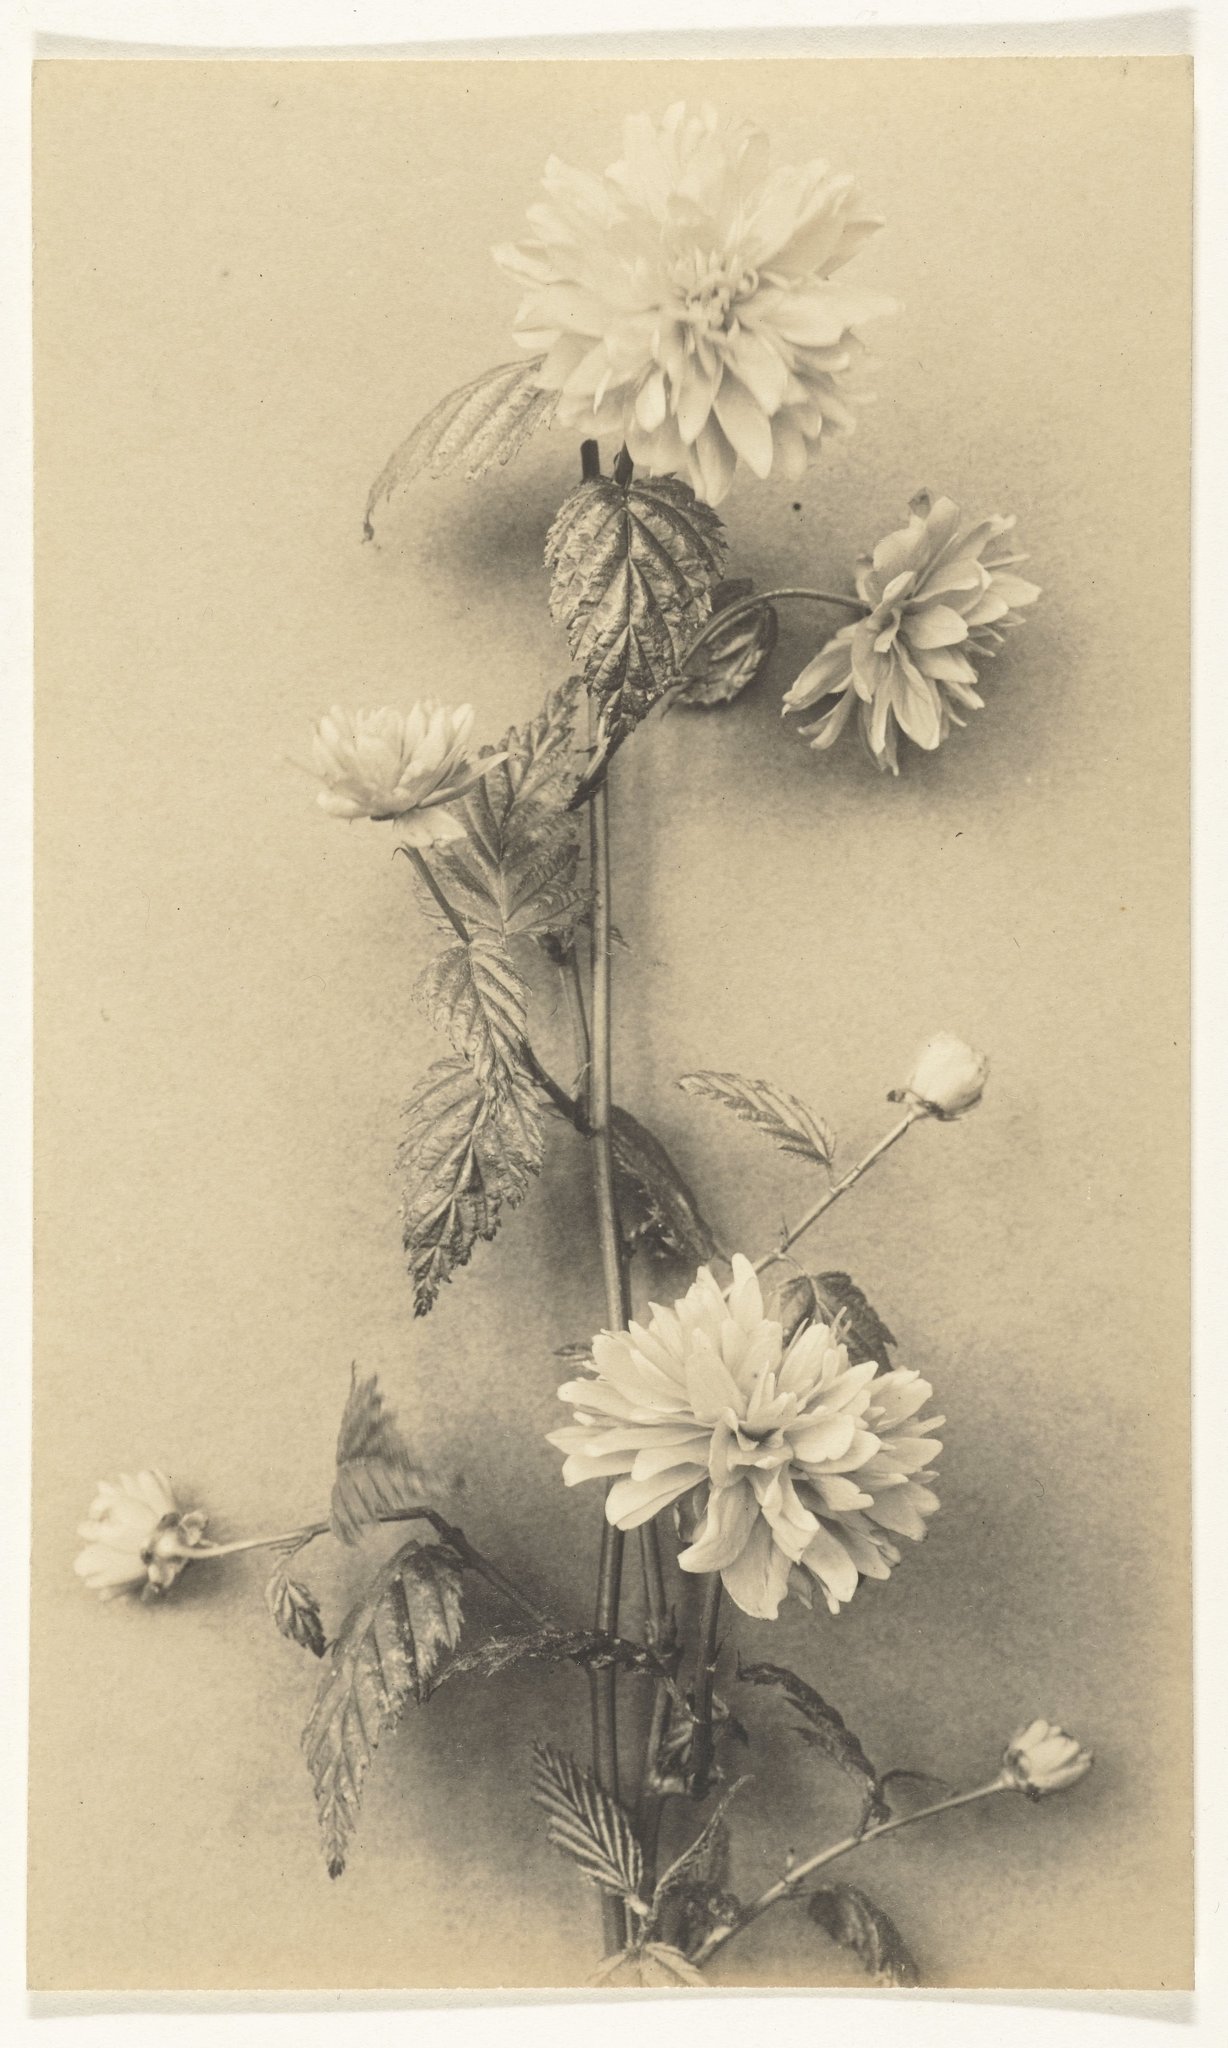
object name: photograph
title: Tak met bloemen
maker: richard tepe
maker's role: fotograaf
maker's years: 1864-1952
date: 1900-1930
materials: photographic support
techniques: albumen print, salted paper print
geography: netherlands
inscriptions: annotation: ‘ac / 3’